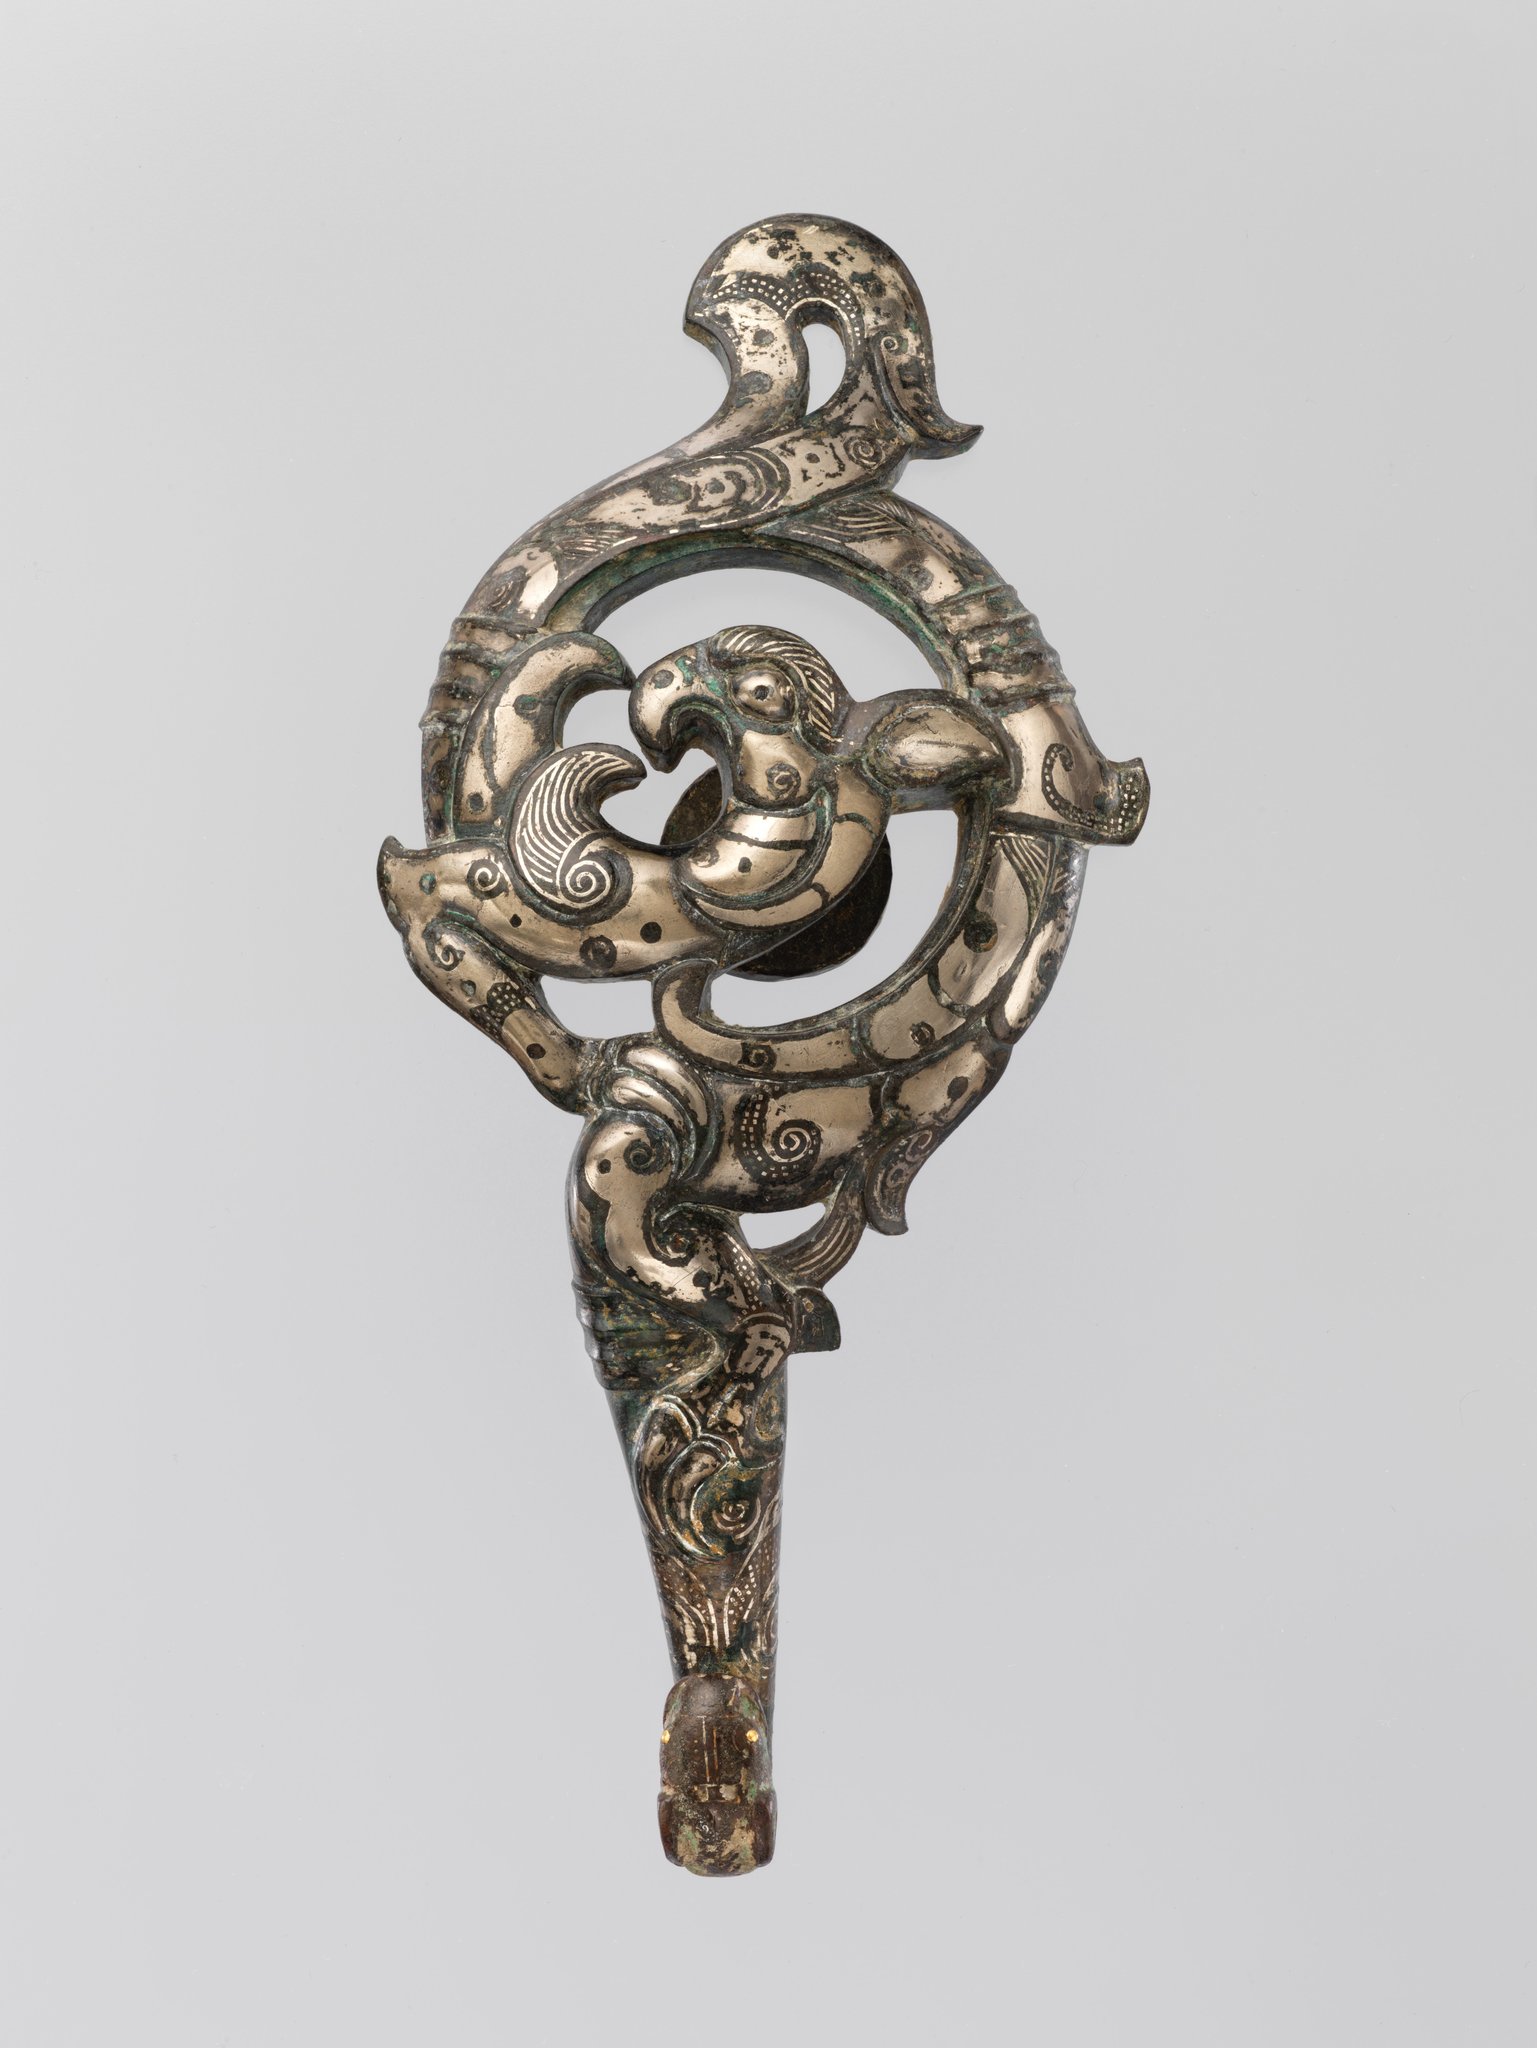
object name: belt hook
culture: chinese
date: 300-101 BCE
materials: bronze, gold, silver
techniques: inlay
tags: mythical creatures